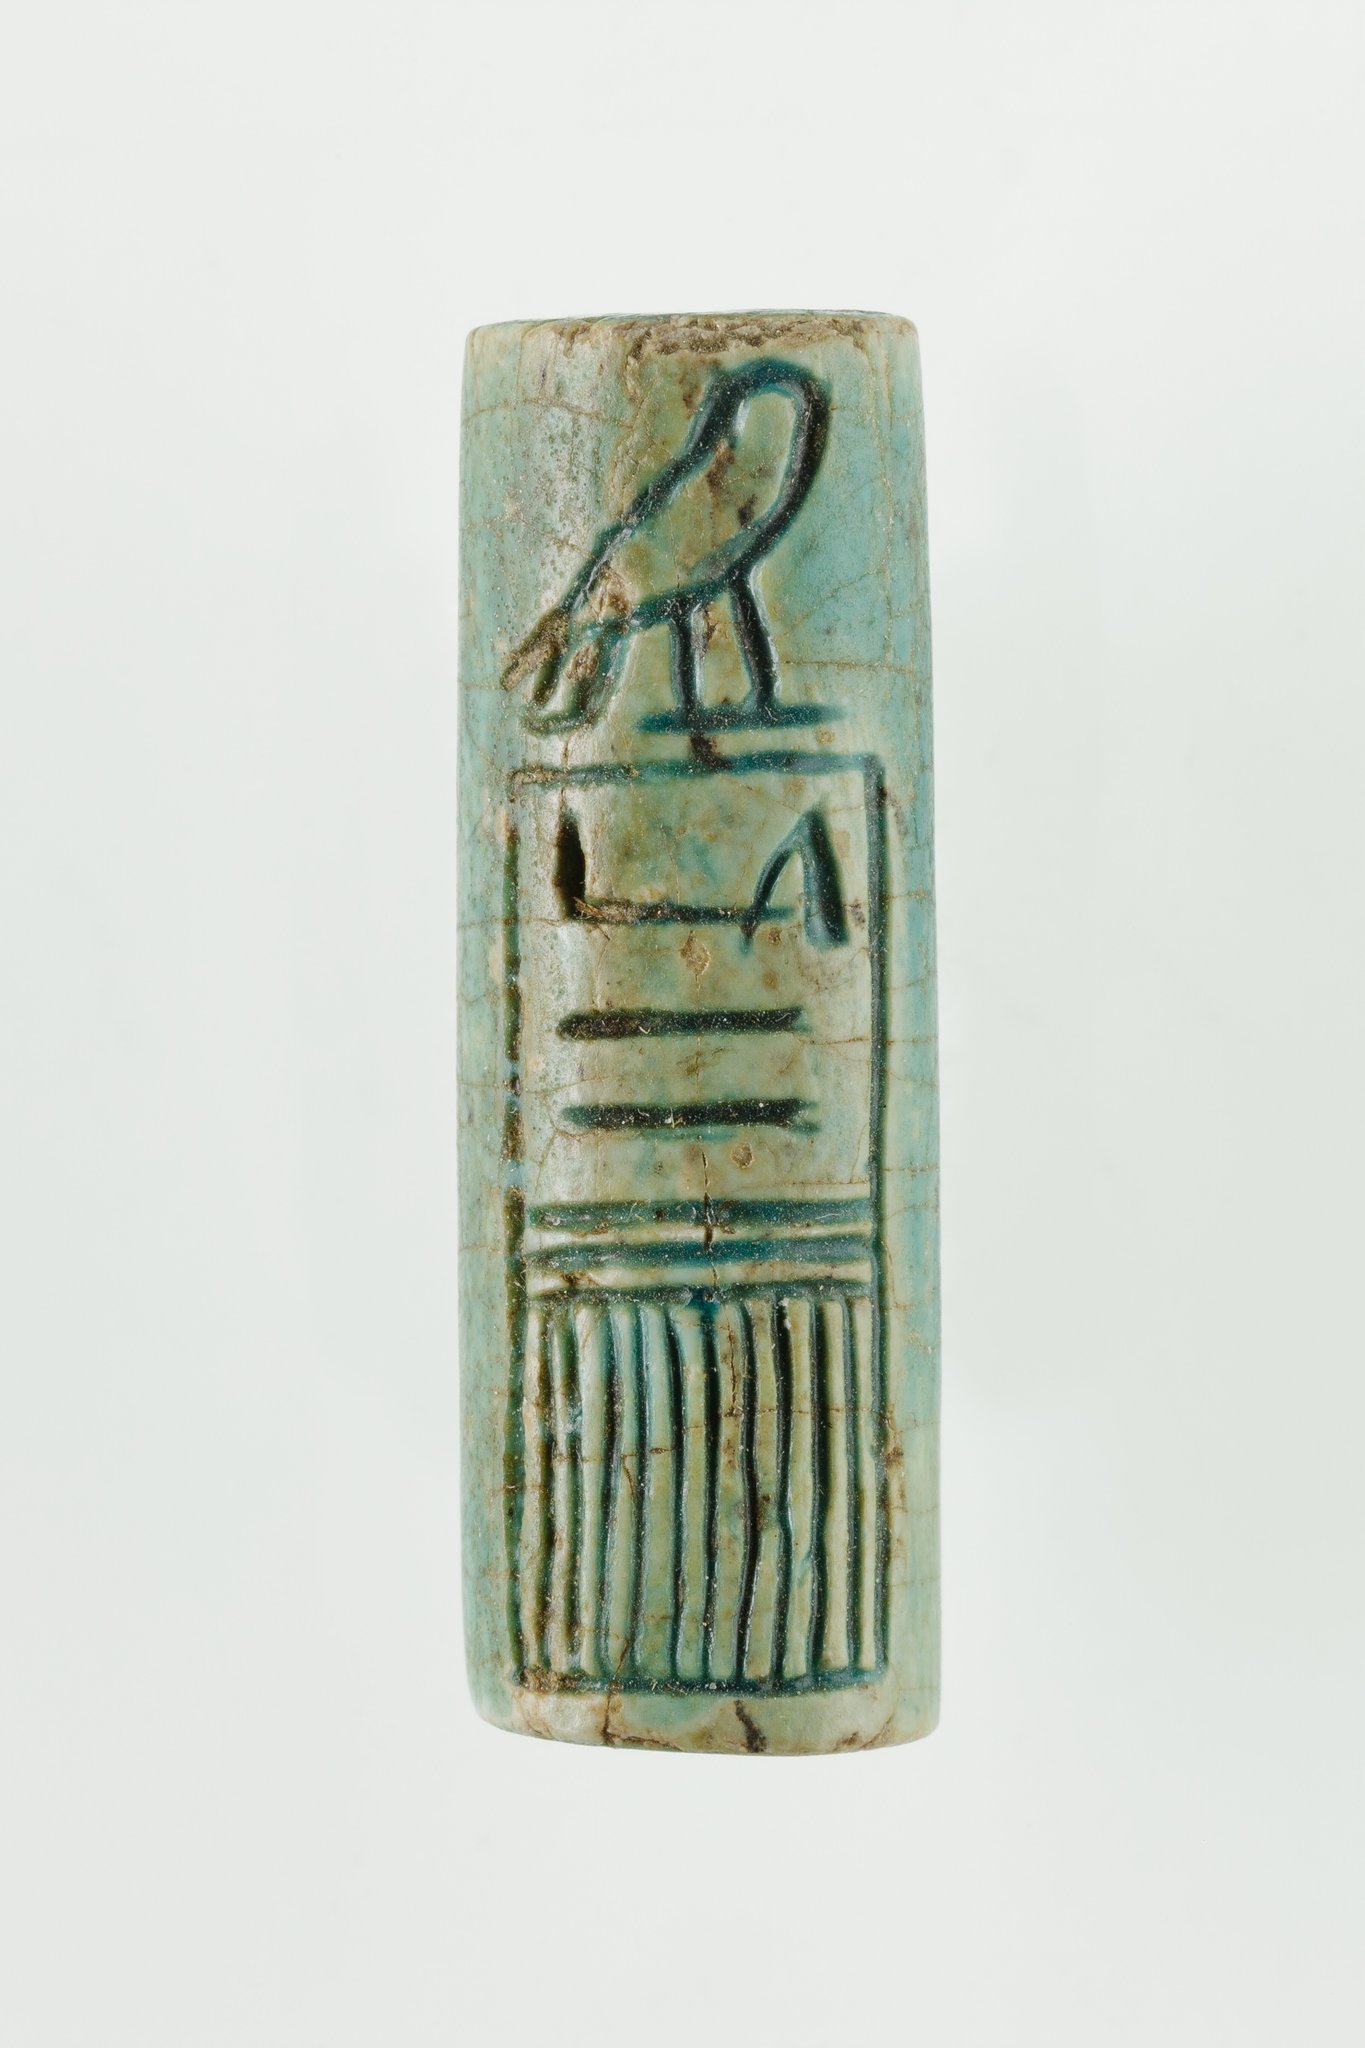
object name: cylinder seal, king sebekhotep iii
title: Cylinder Seal of King Sekhemre Sewadjtawy Sebekhotep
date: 1748-1741 BCE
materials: stone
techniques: glazing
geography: egypt